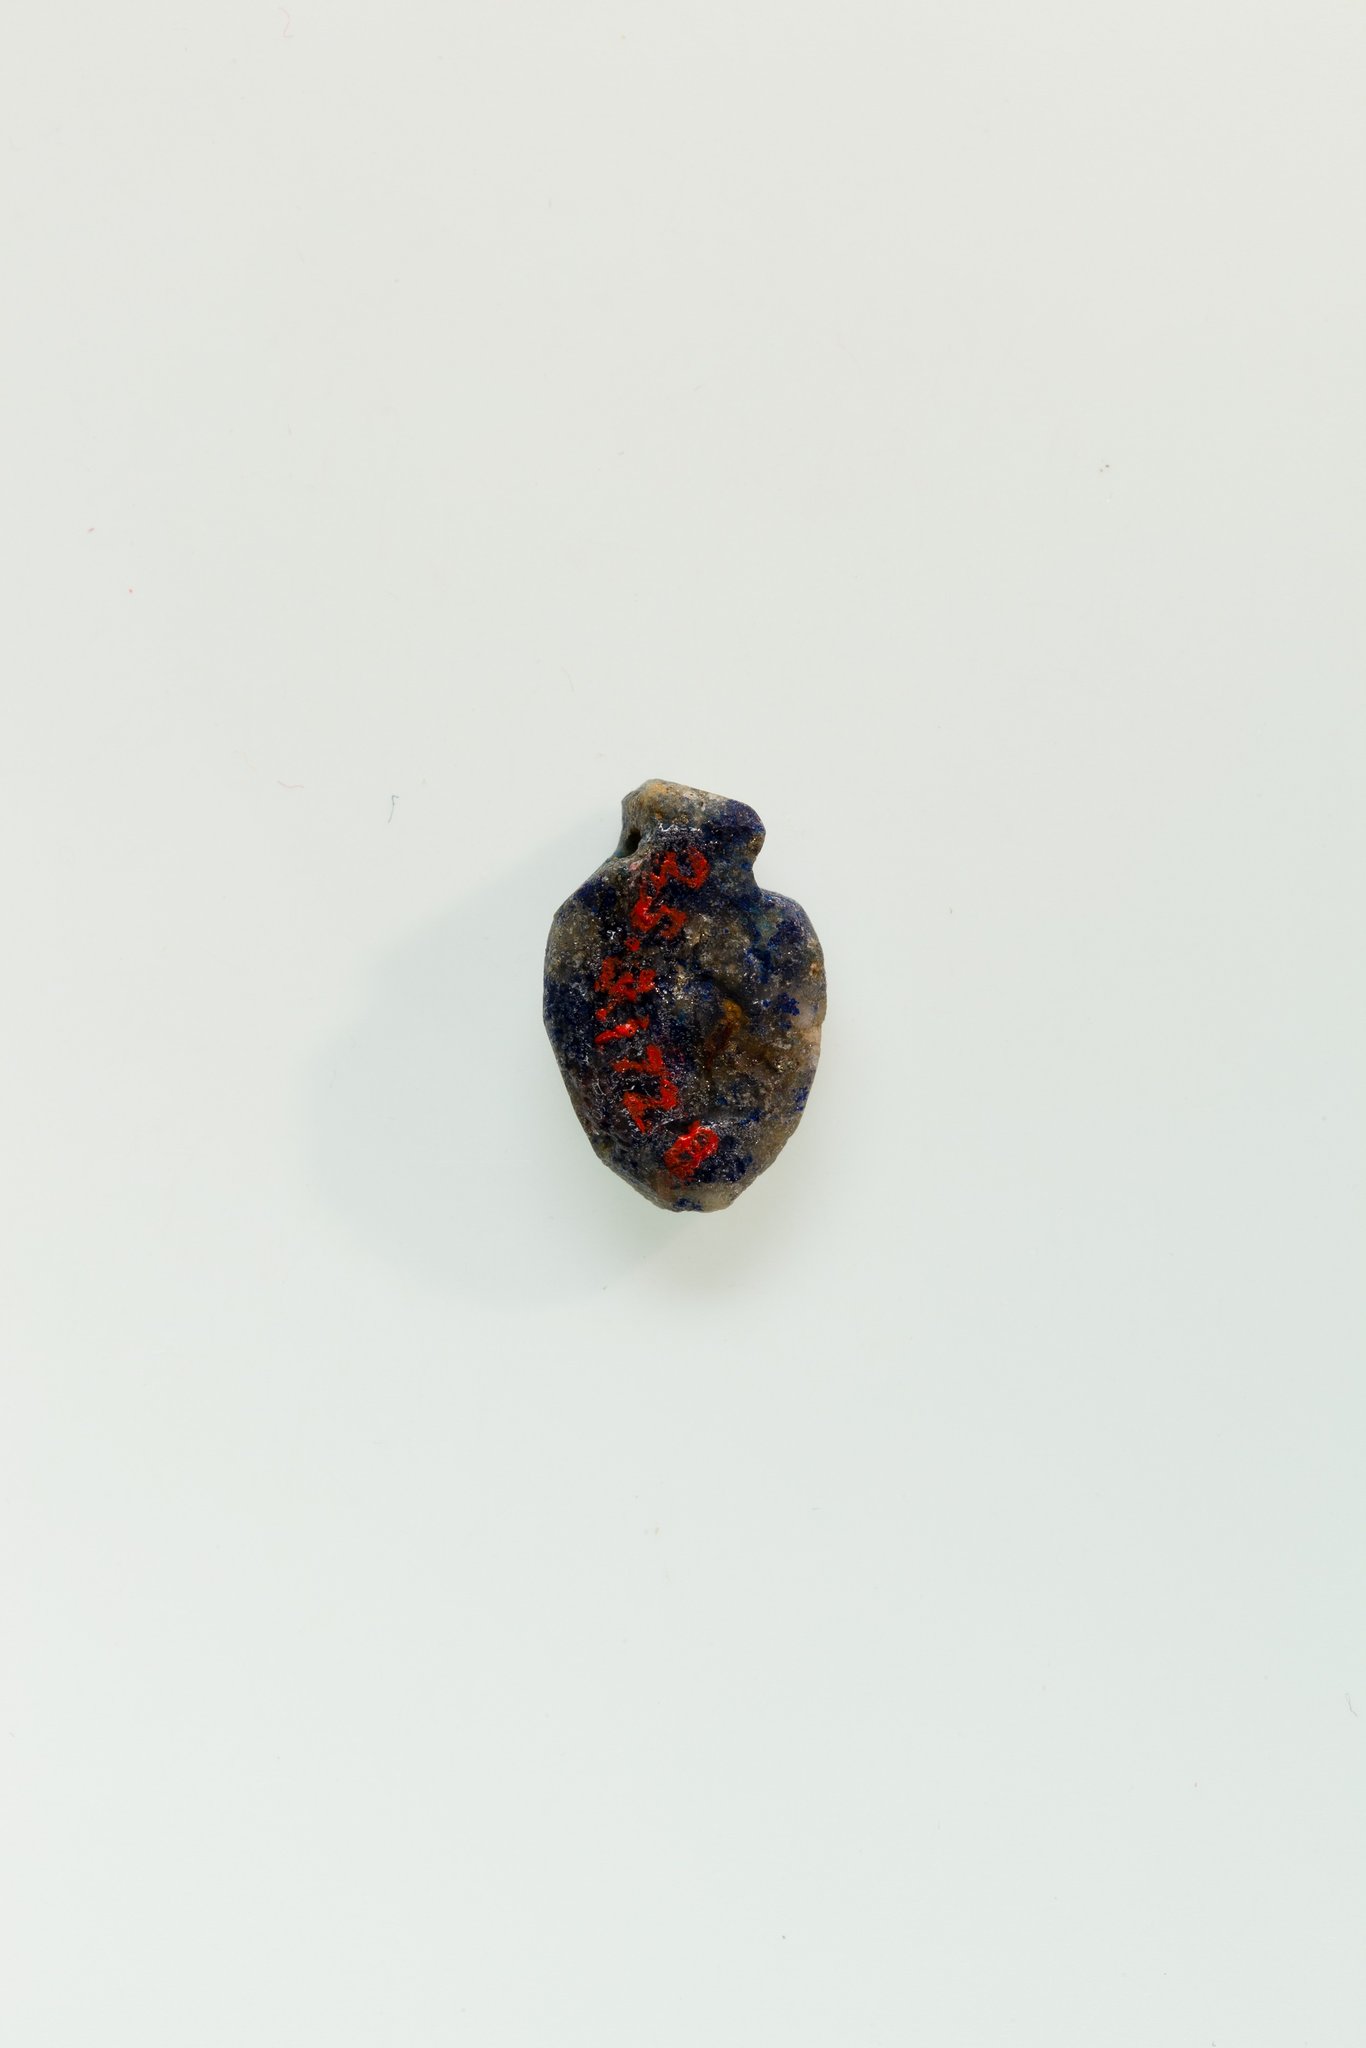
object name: amulet, heart, tiye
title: Heart Amulet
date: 1070-945 BCE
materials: lapis lazuli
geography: egypt